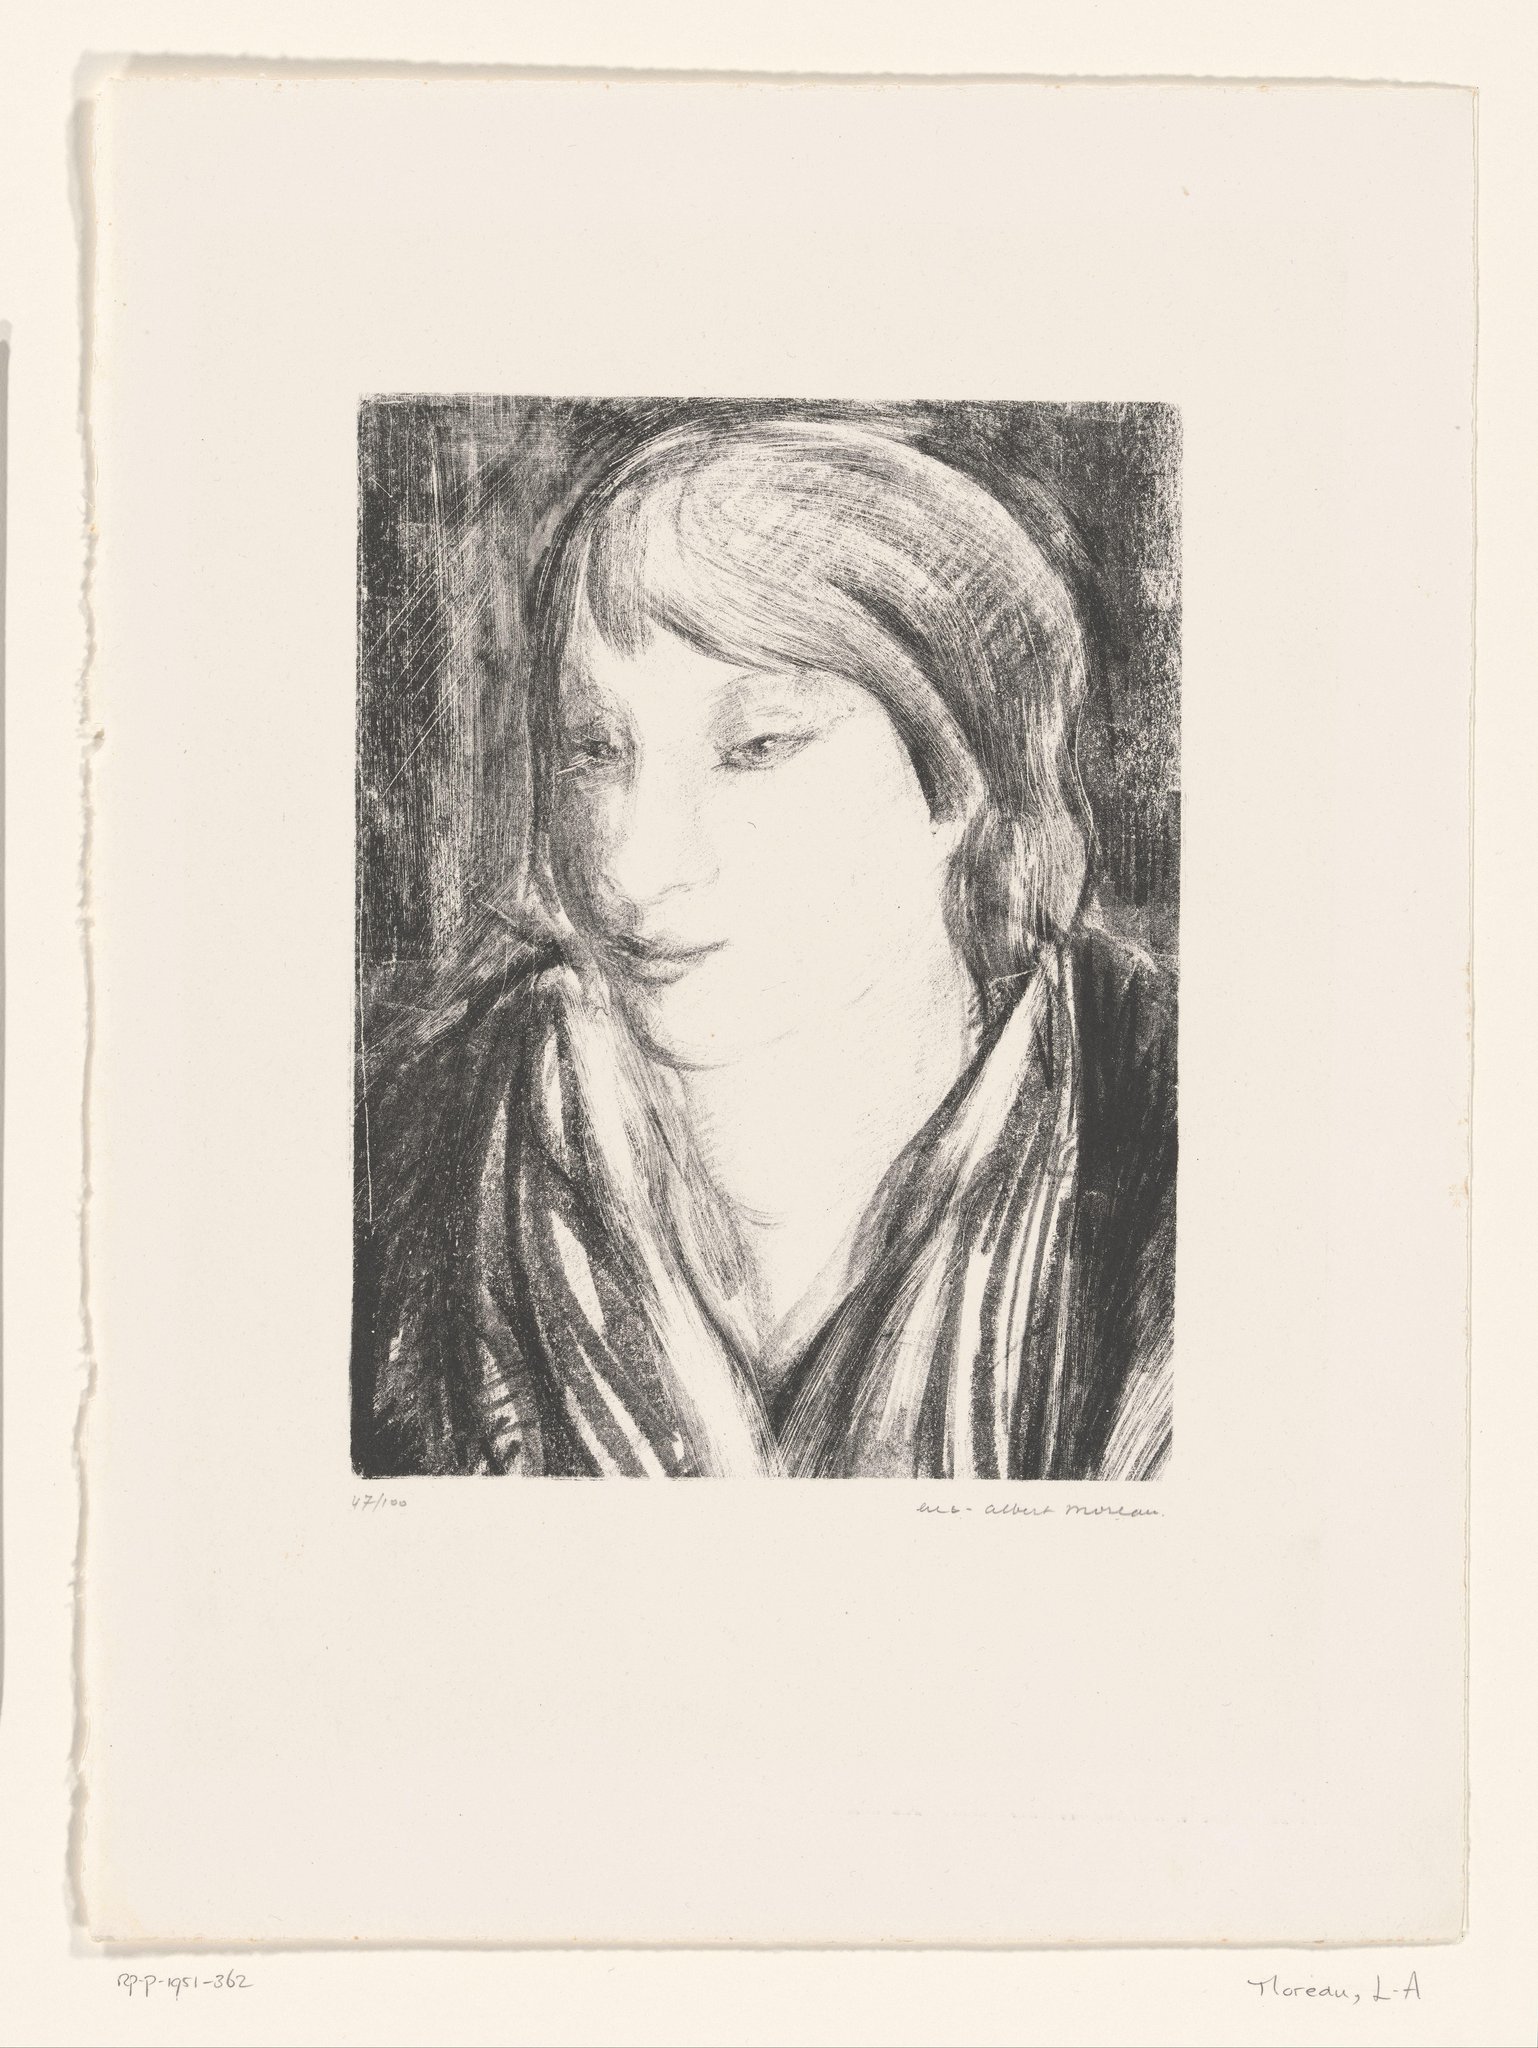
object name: print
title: Portret van een onbekende vrouw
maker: luc-albert moreau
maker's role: print maker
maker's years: 1882-1948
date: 1892-1948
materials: paper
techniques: lithograph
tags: adolescent, young woman, maiden, historical persons not known by name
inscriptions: collector's mark: Lugt 2228